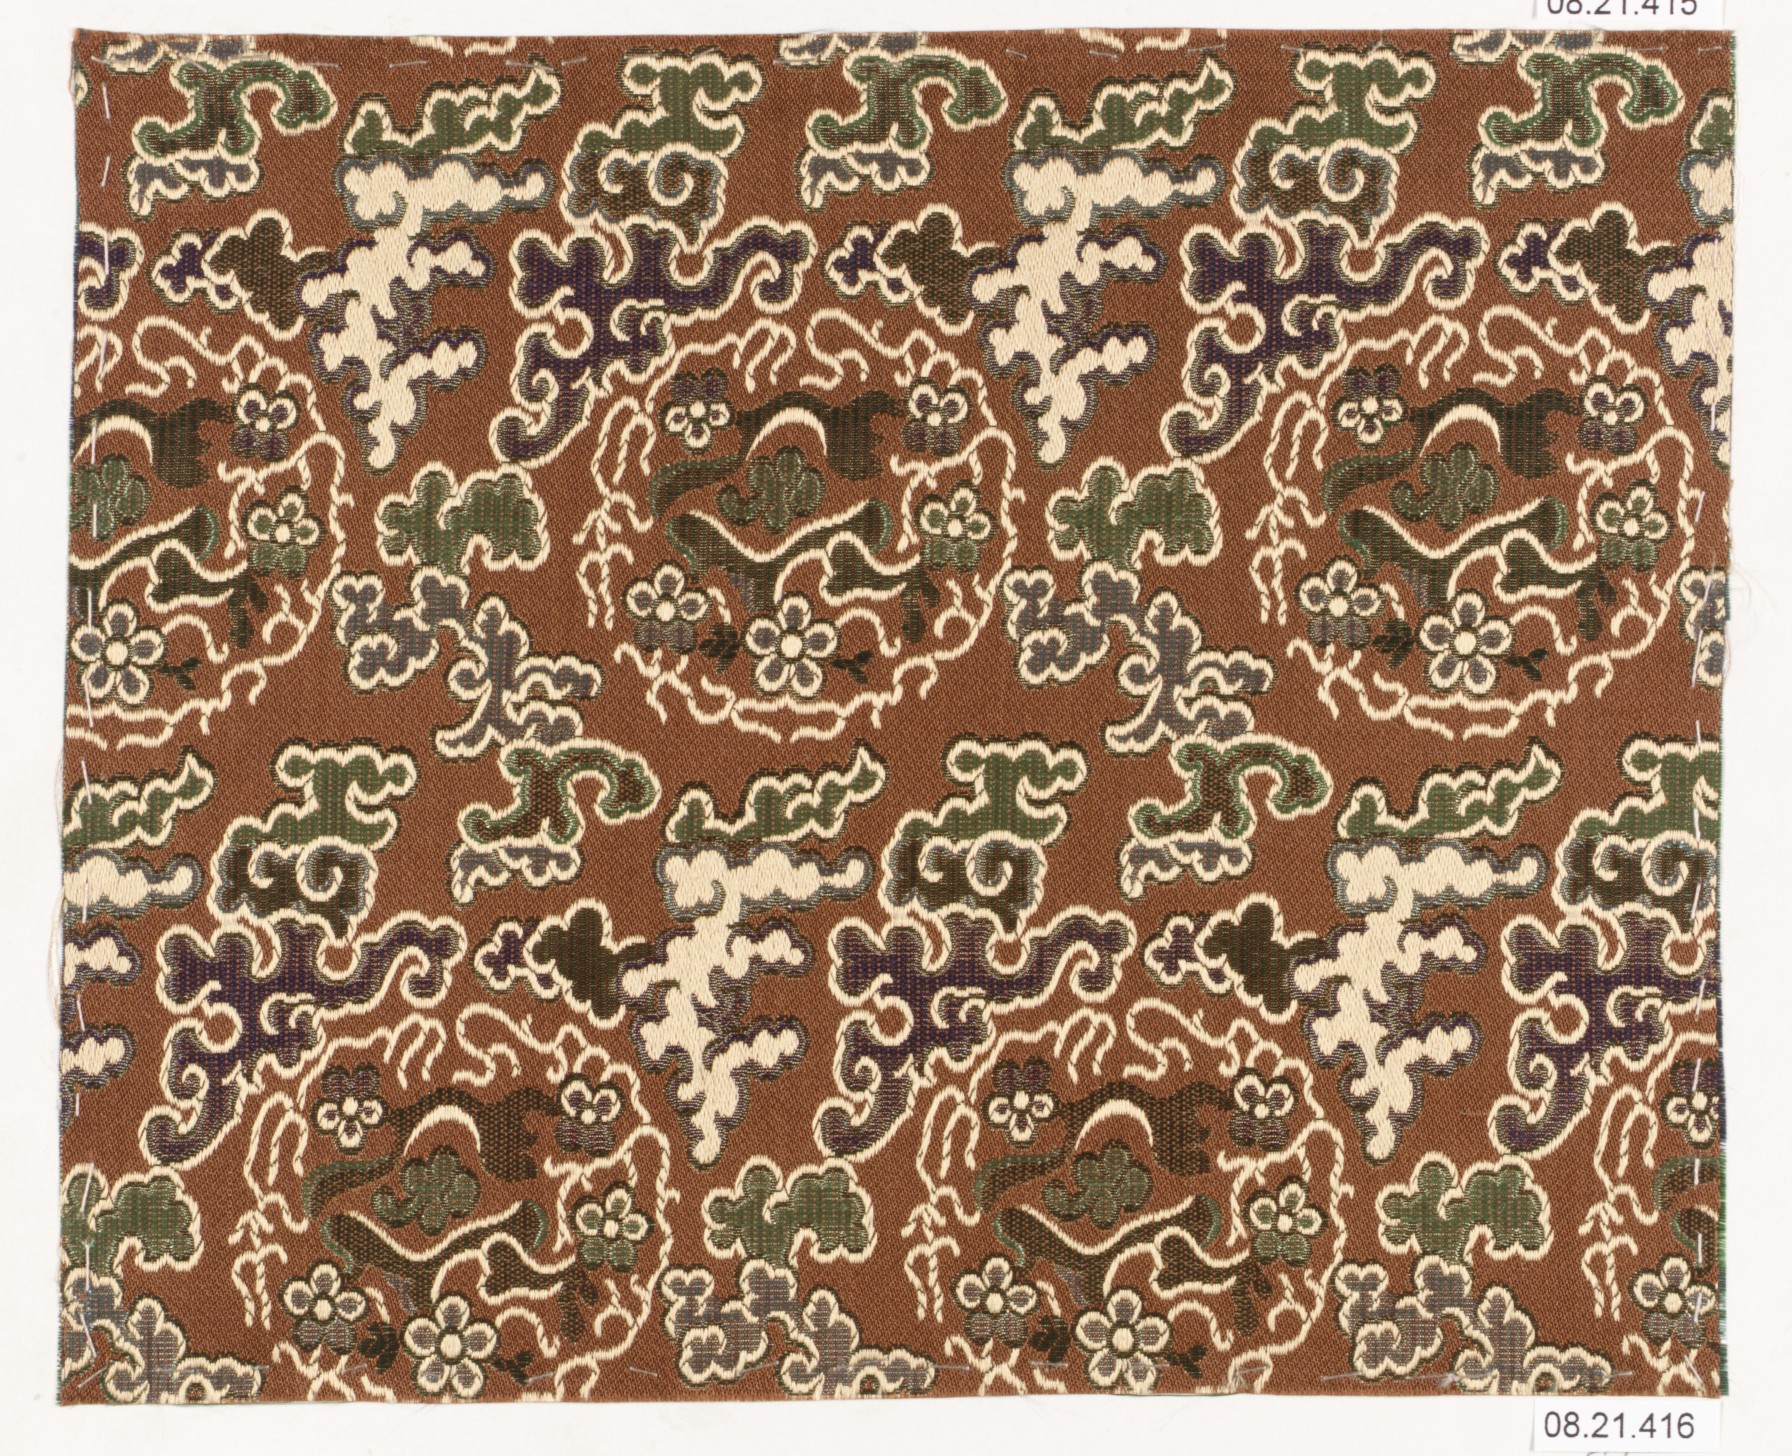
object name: textile sample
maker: Anonymous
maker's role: designer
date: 1900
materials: silk